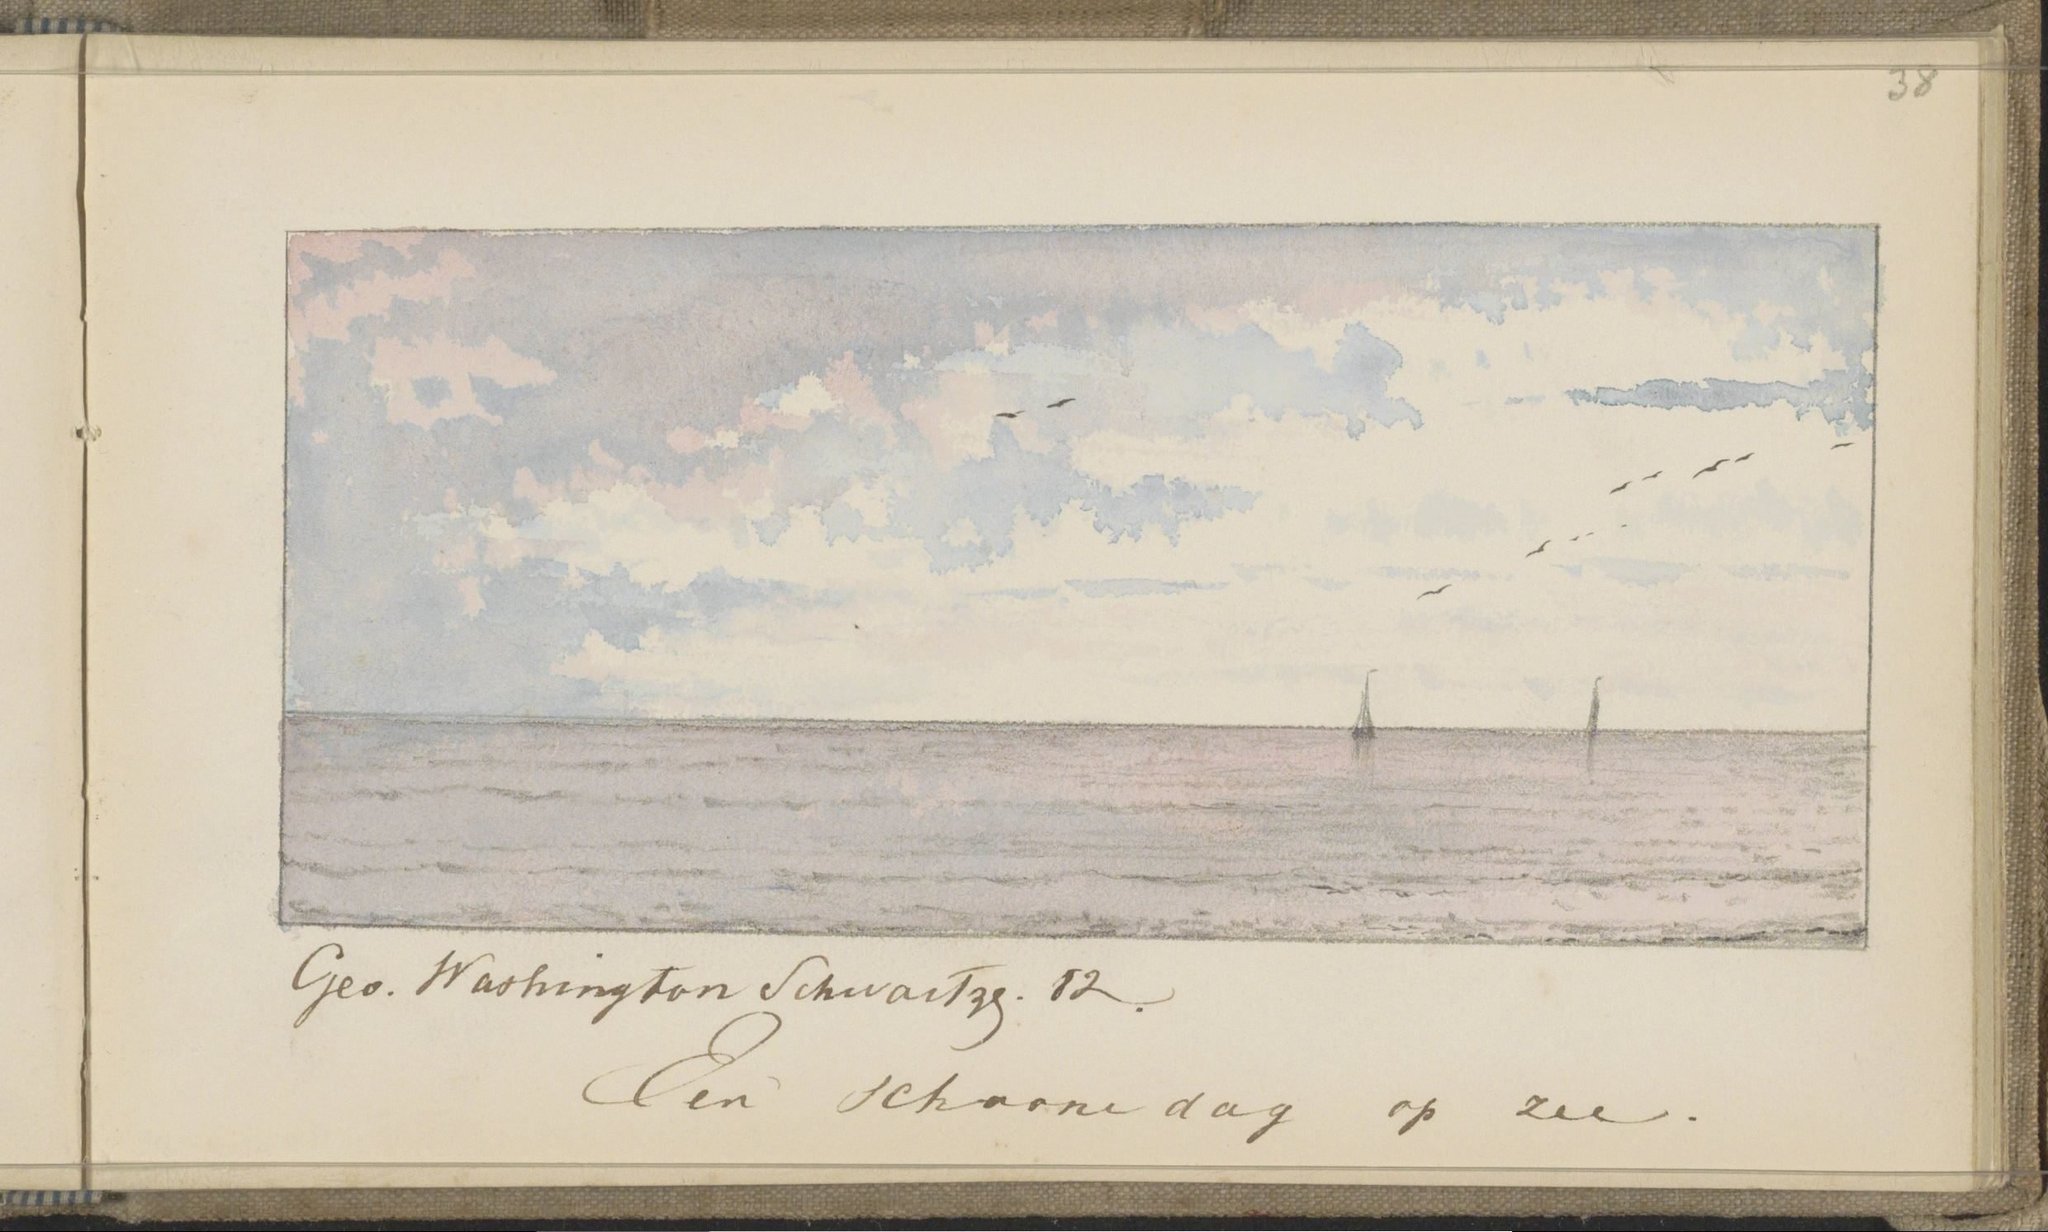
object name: sketchbook leaf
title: Een schoone dag op zee.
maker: george washington schwartze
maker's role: draughtsman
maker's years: 1857-1909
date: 1882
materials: ink, paper, pencil, watercolor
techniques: brush, pen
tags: sea (seascape)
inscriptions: signature and date: ‘Geo. Washington Schwartze. 82.’, title: ‘Een schoone dag op zee.’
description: Tekening in een kader. Blad 38 recto uit een schetsboek met 54 bladen.